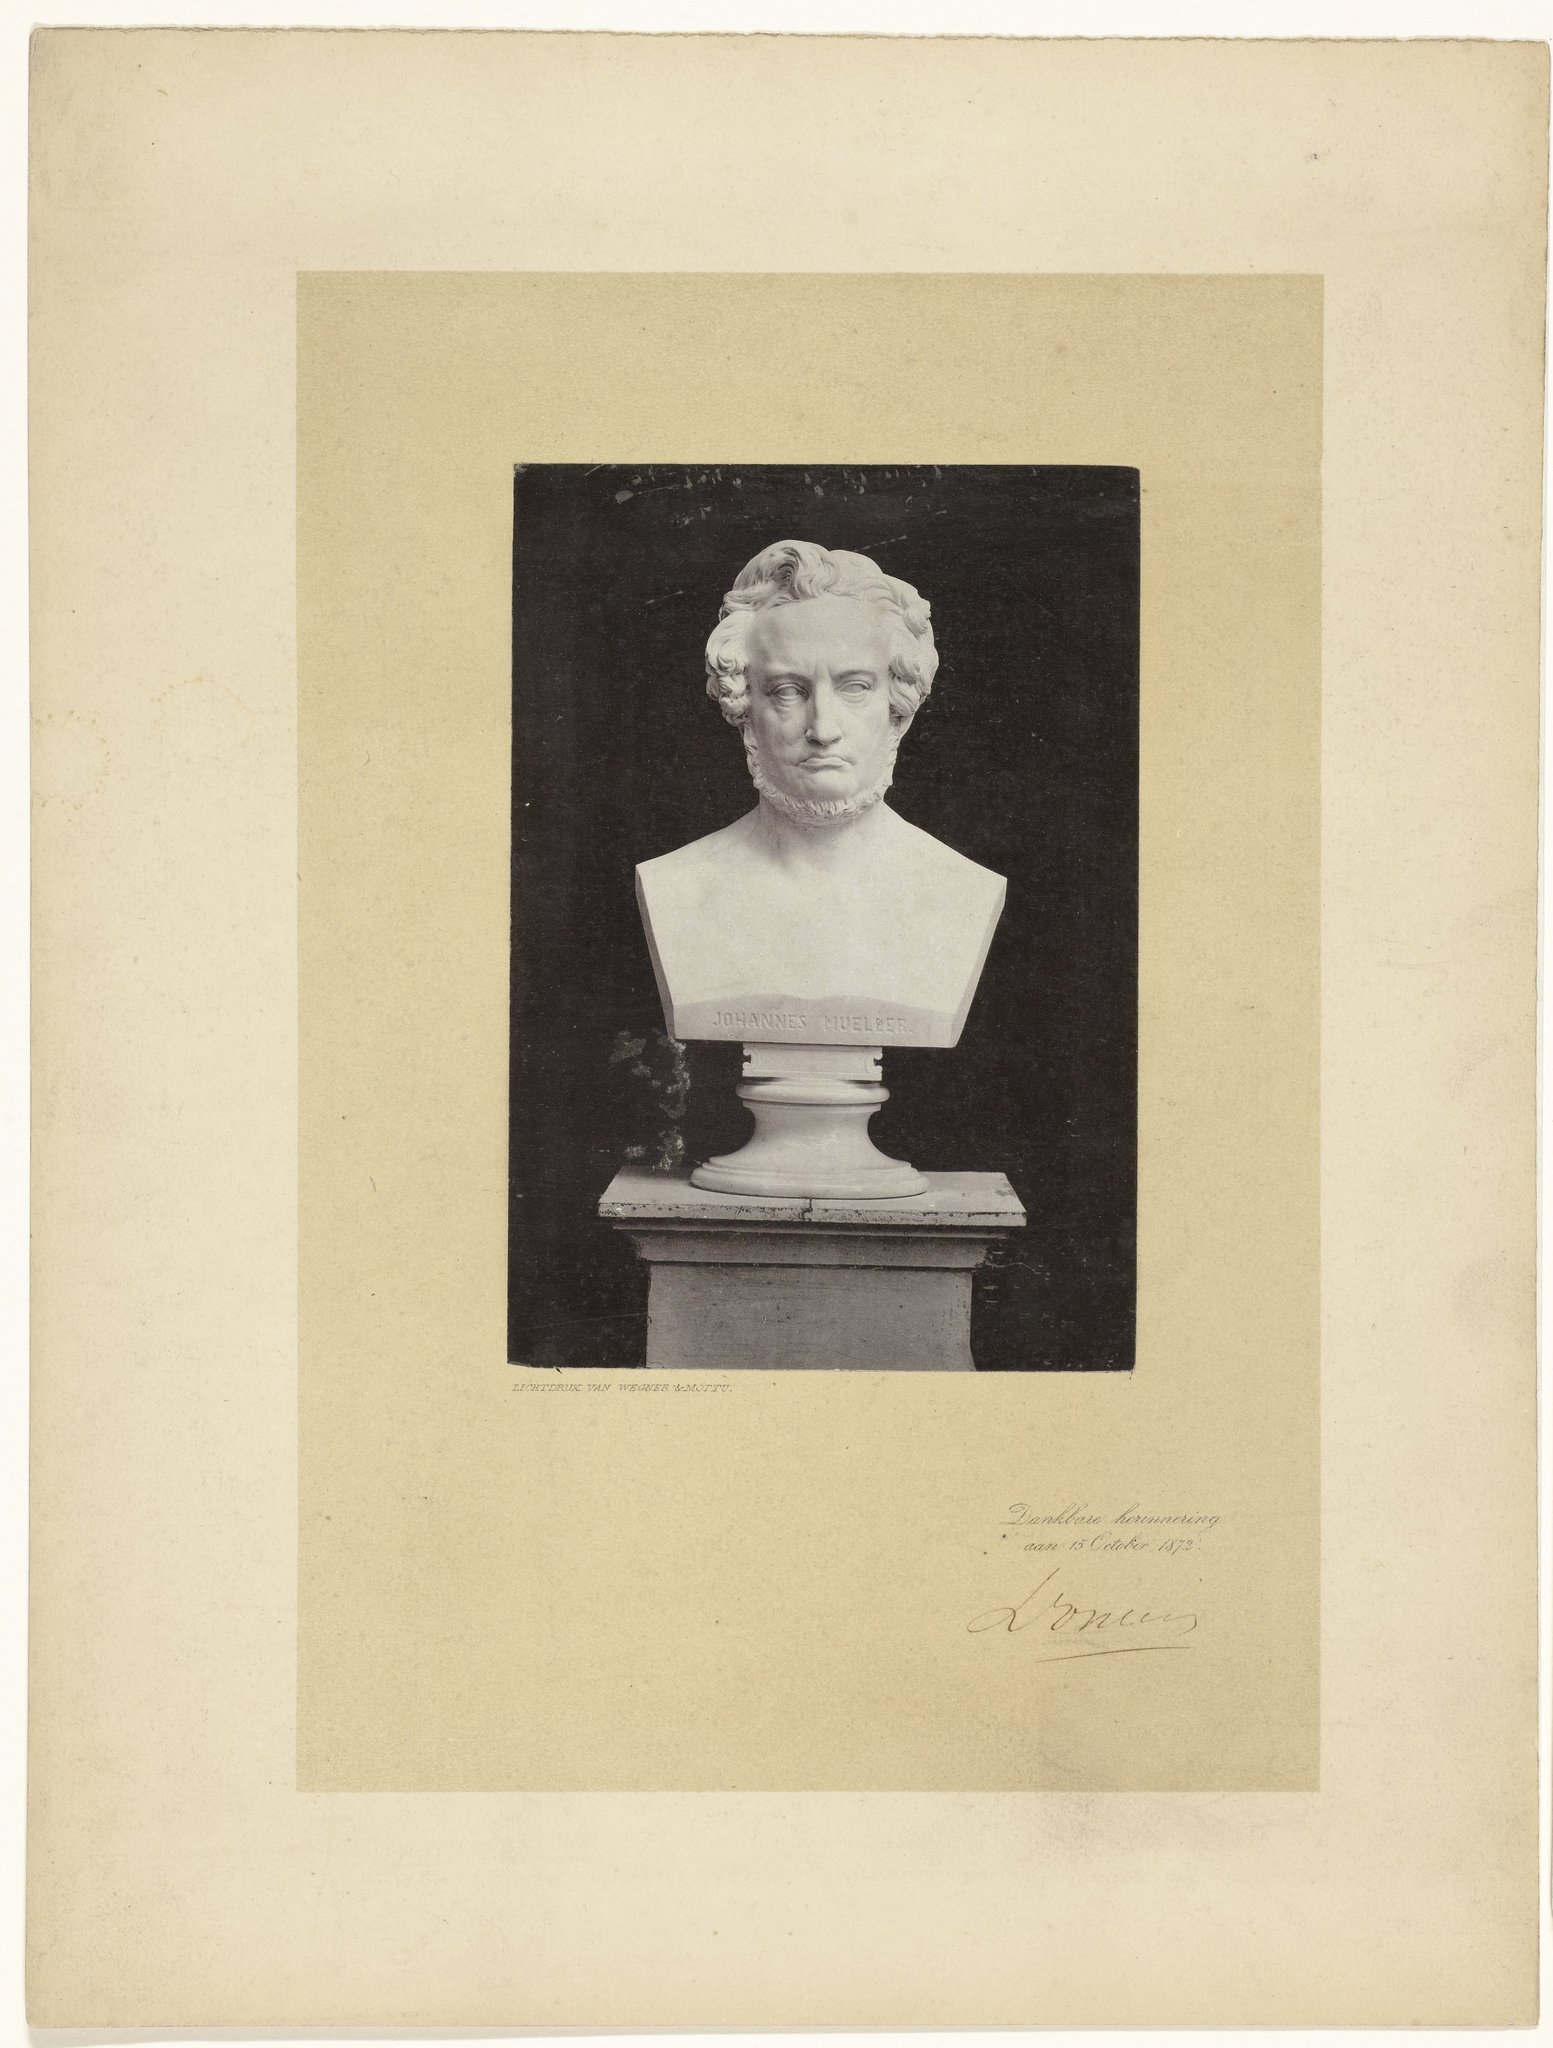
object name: photograph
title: Borstbeeld van Johannes Mueller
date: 1872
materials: cardboard, paper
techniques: photograph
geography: amsterdam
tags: historical persons, science and technology (+ portrait of scholar, scientist)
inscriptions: annotation: ‘Dankbare herinnering aan 15 october 18721872’, signature and date: ‘Lichtdruk van Wegner & Mottu.’